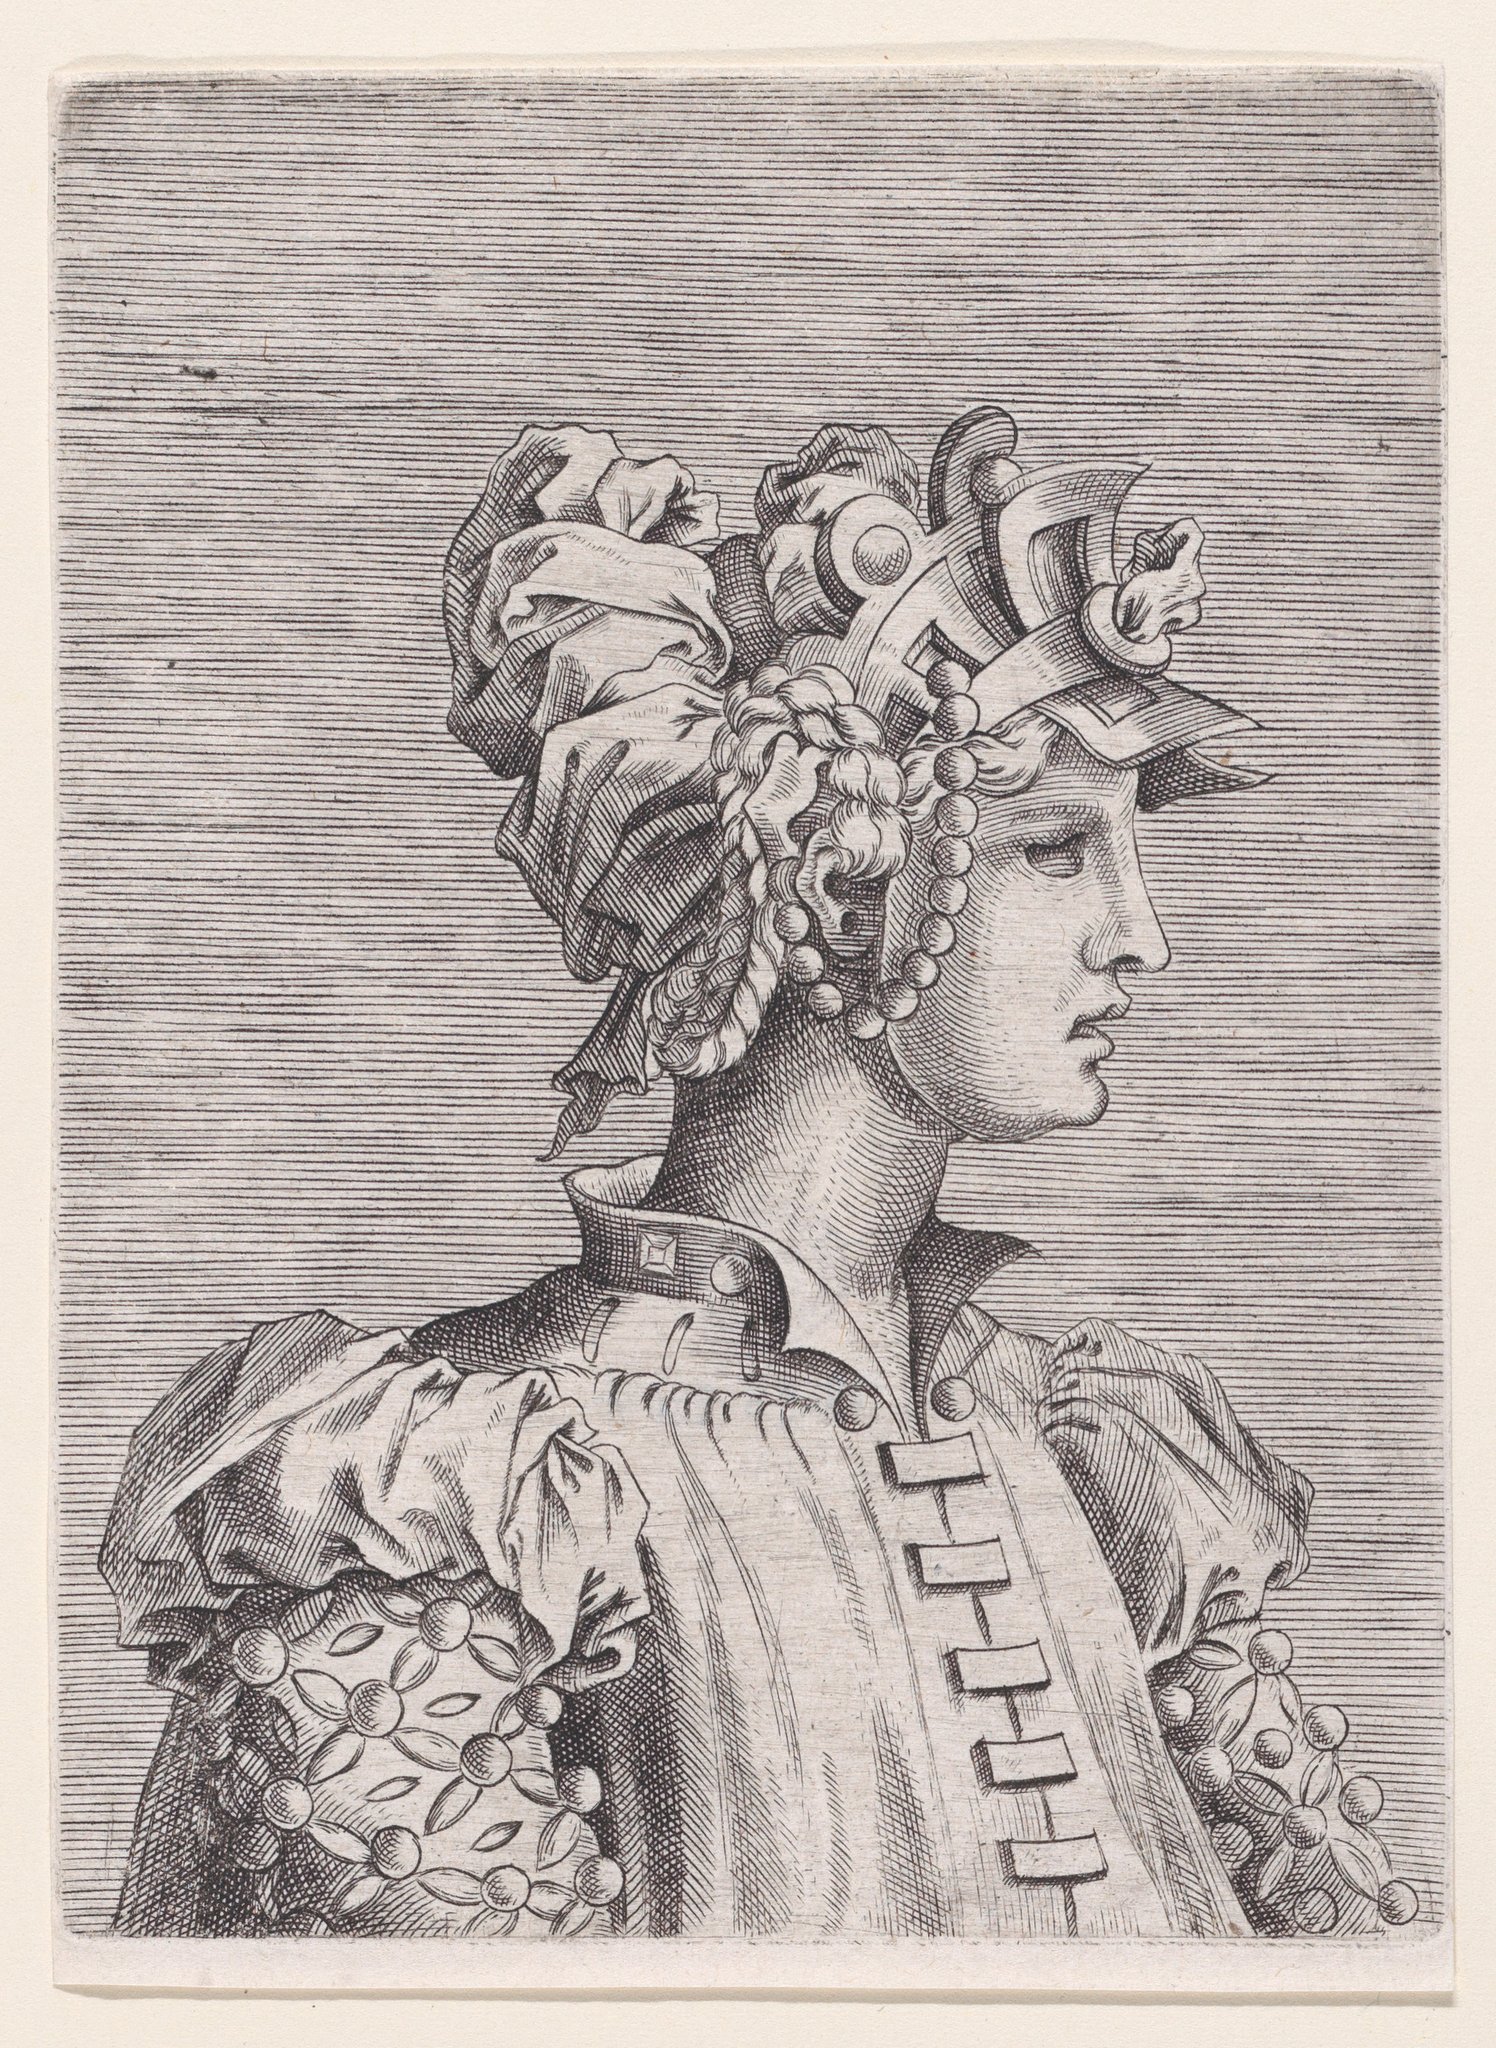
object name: print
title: Bust of a Woman Wearing a Fantastic Head-dress and Mask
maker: rené boyvin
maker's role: artist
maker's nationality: french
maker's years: 1525-1598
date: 1525-1600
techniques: etching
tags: masks,women,headdresses